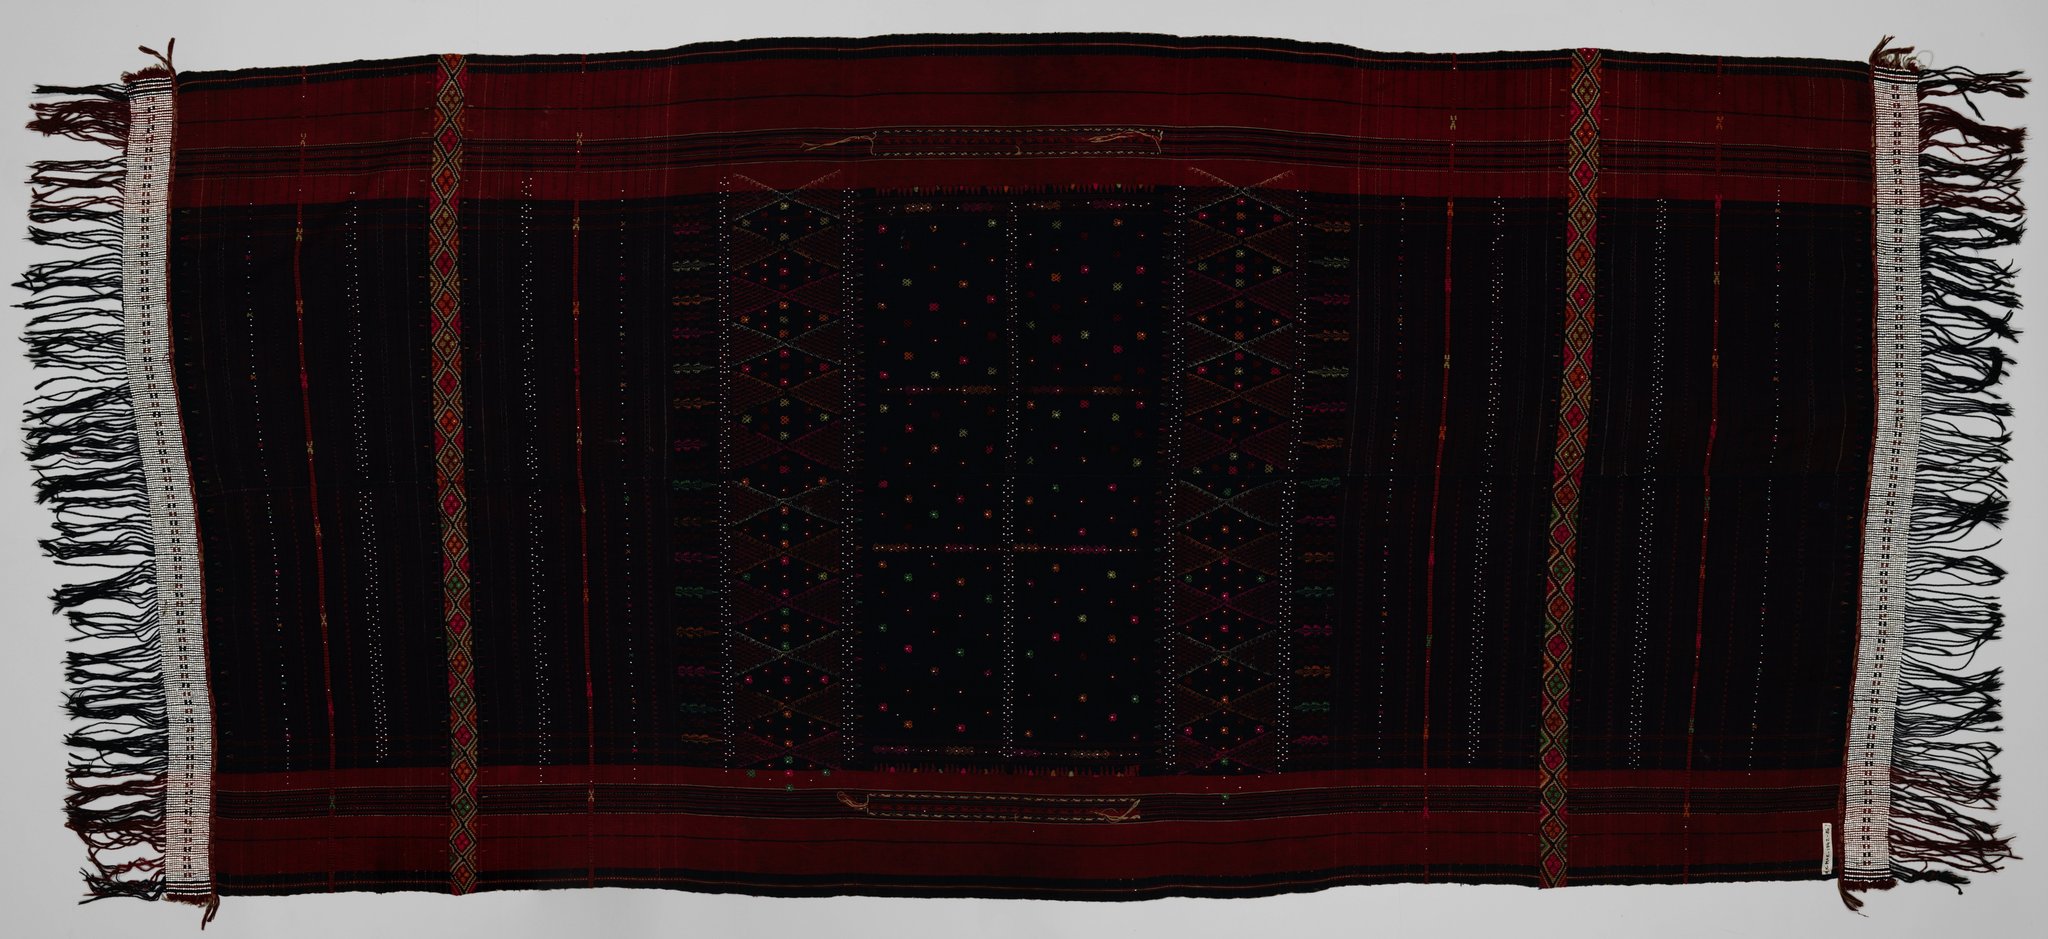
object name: cloth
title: Ulos godang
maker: Anonymous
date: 1900-1999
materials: cotton, glass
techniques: weave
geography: sumatra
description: Ceremoniële doek die door de grootouders van moederskant als huwelijksgift wordt mee gegeven.